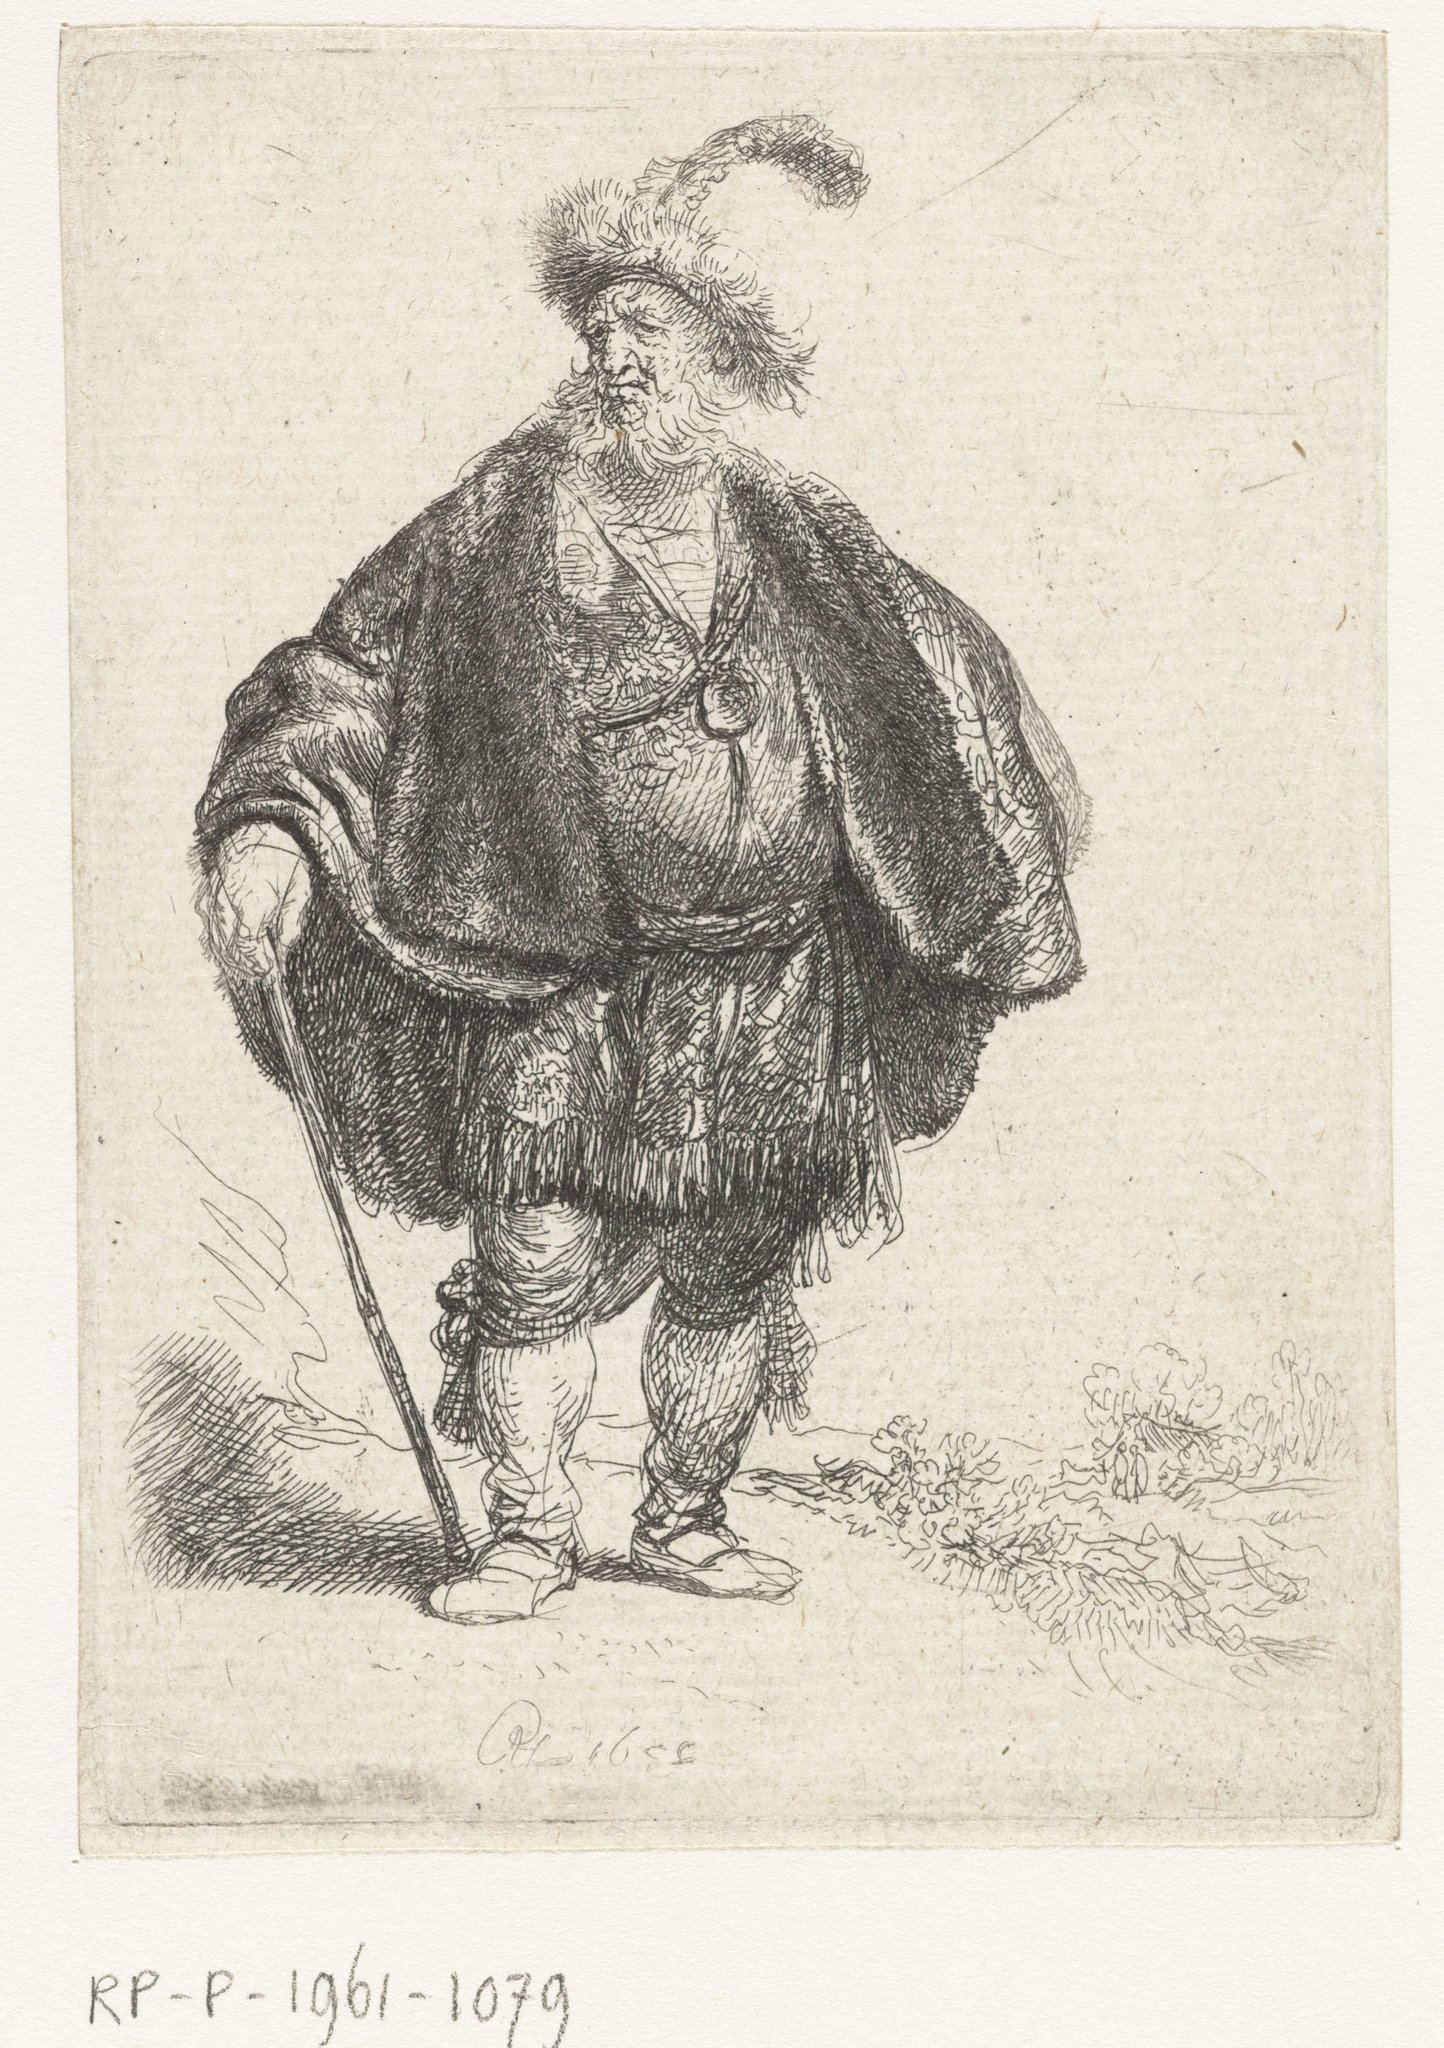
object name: print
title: The Persian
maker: rembrandt van rijn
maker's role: draughtsman, painter, print maker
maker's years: 1606-1669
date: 1632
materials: paper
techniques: etching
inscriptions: collector's mark: Lugt 2100 b, monogram and date: ‘RHL 1632’ Lugt, collector's mark: Lugt 2228